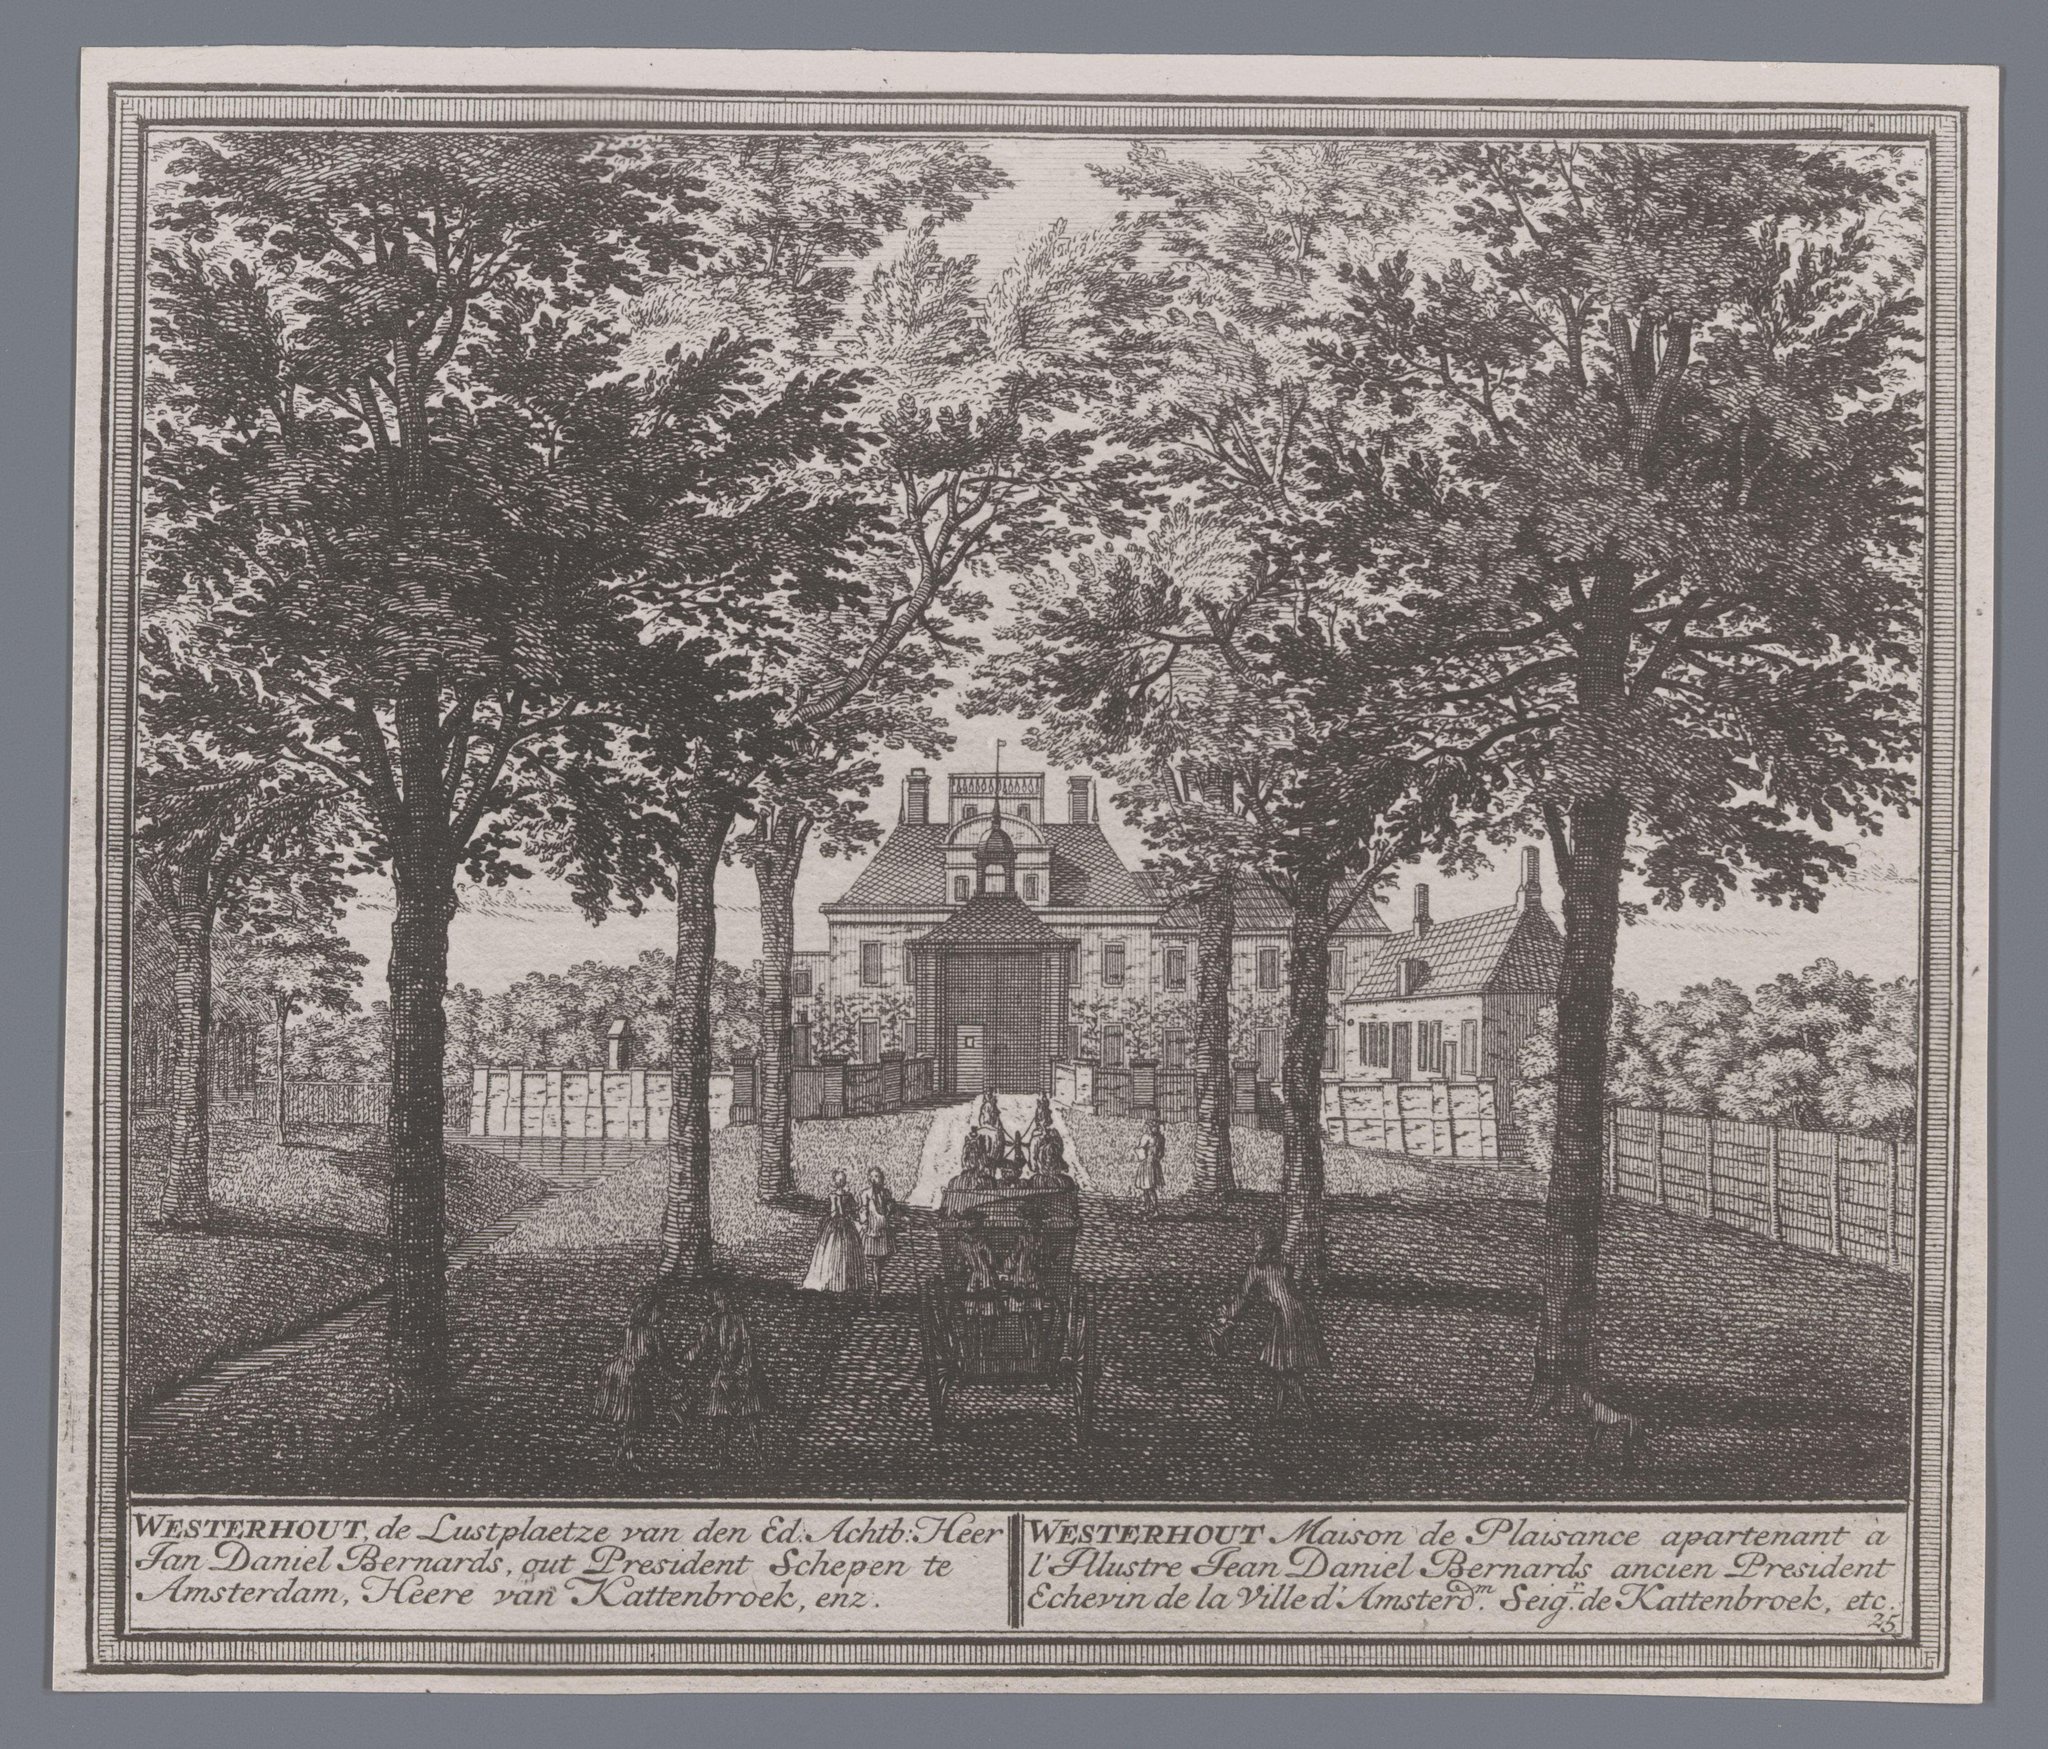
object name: photograph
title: Fotoreproductie van een prent van een gezicht op de buitenplaats Westerhout te Beverwijk door Hendrik de Leth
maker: Anonymous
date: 1900-1930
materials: photographic support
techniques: gelatin silver print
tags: villa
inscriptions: inscription: ‘Westerhout, de Lustplaetze van den Ed. Achtb. Heer Jan Daniel Bernards, out President Schepen te Amsterdam, Heere van Kattenbroek, enz.’, number: ‘'22.76.’, collector's mark: Lugt 2233, annotation: ‘Heemstede’